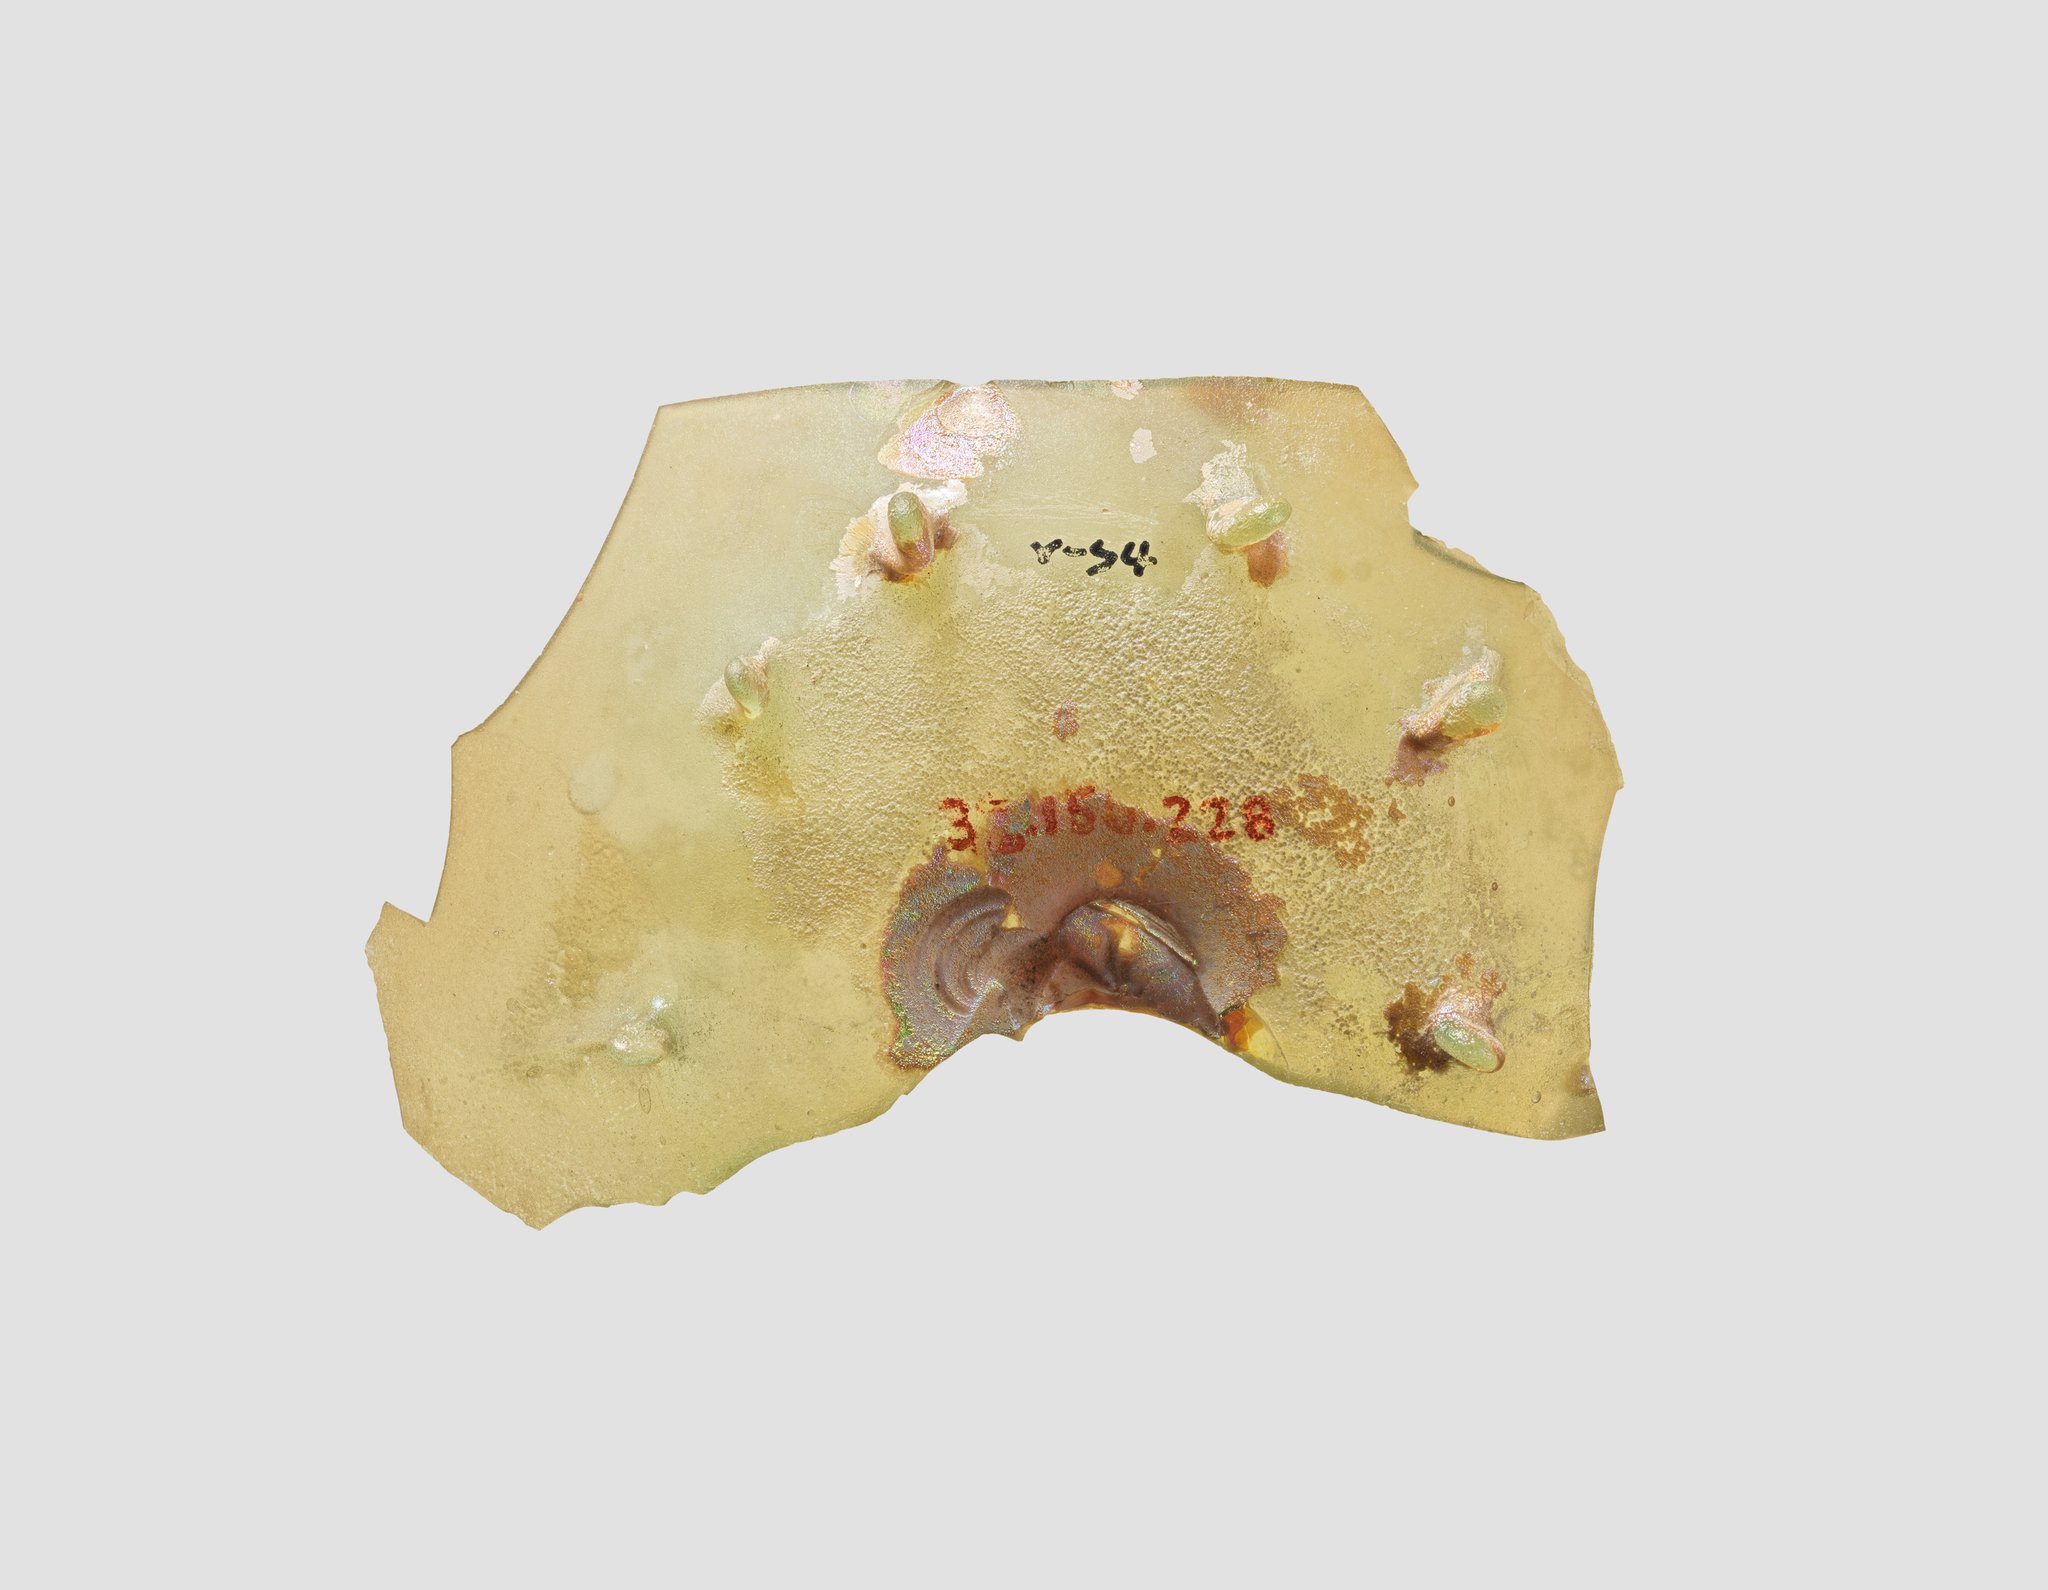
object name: bowl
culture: sasanian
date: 201-700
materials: glass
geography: mesopotamia